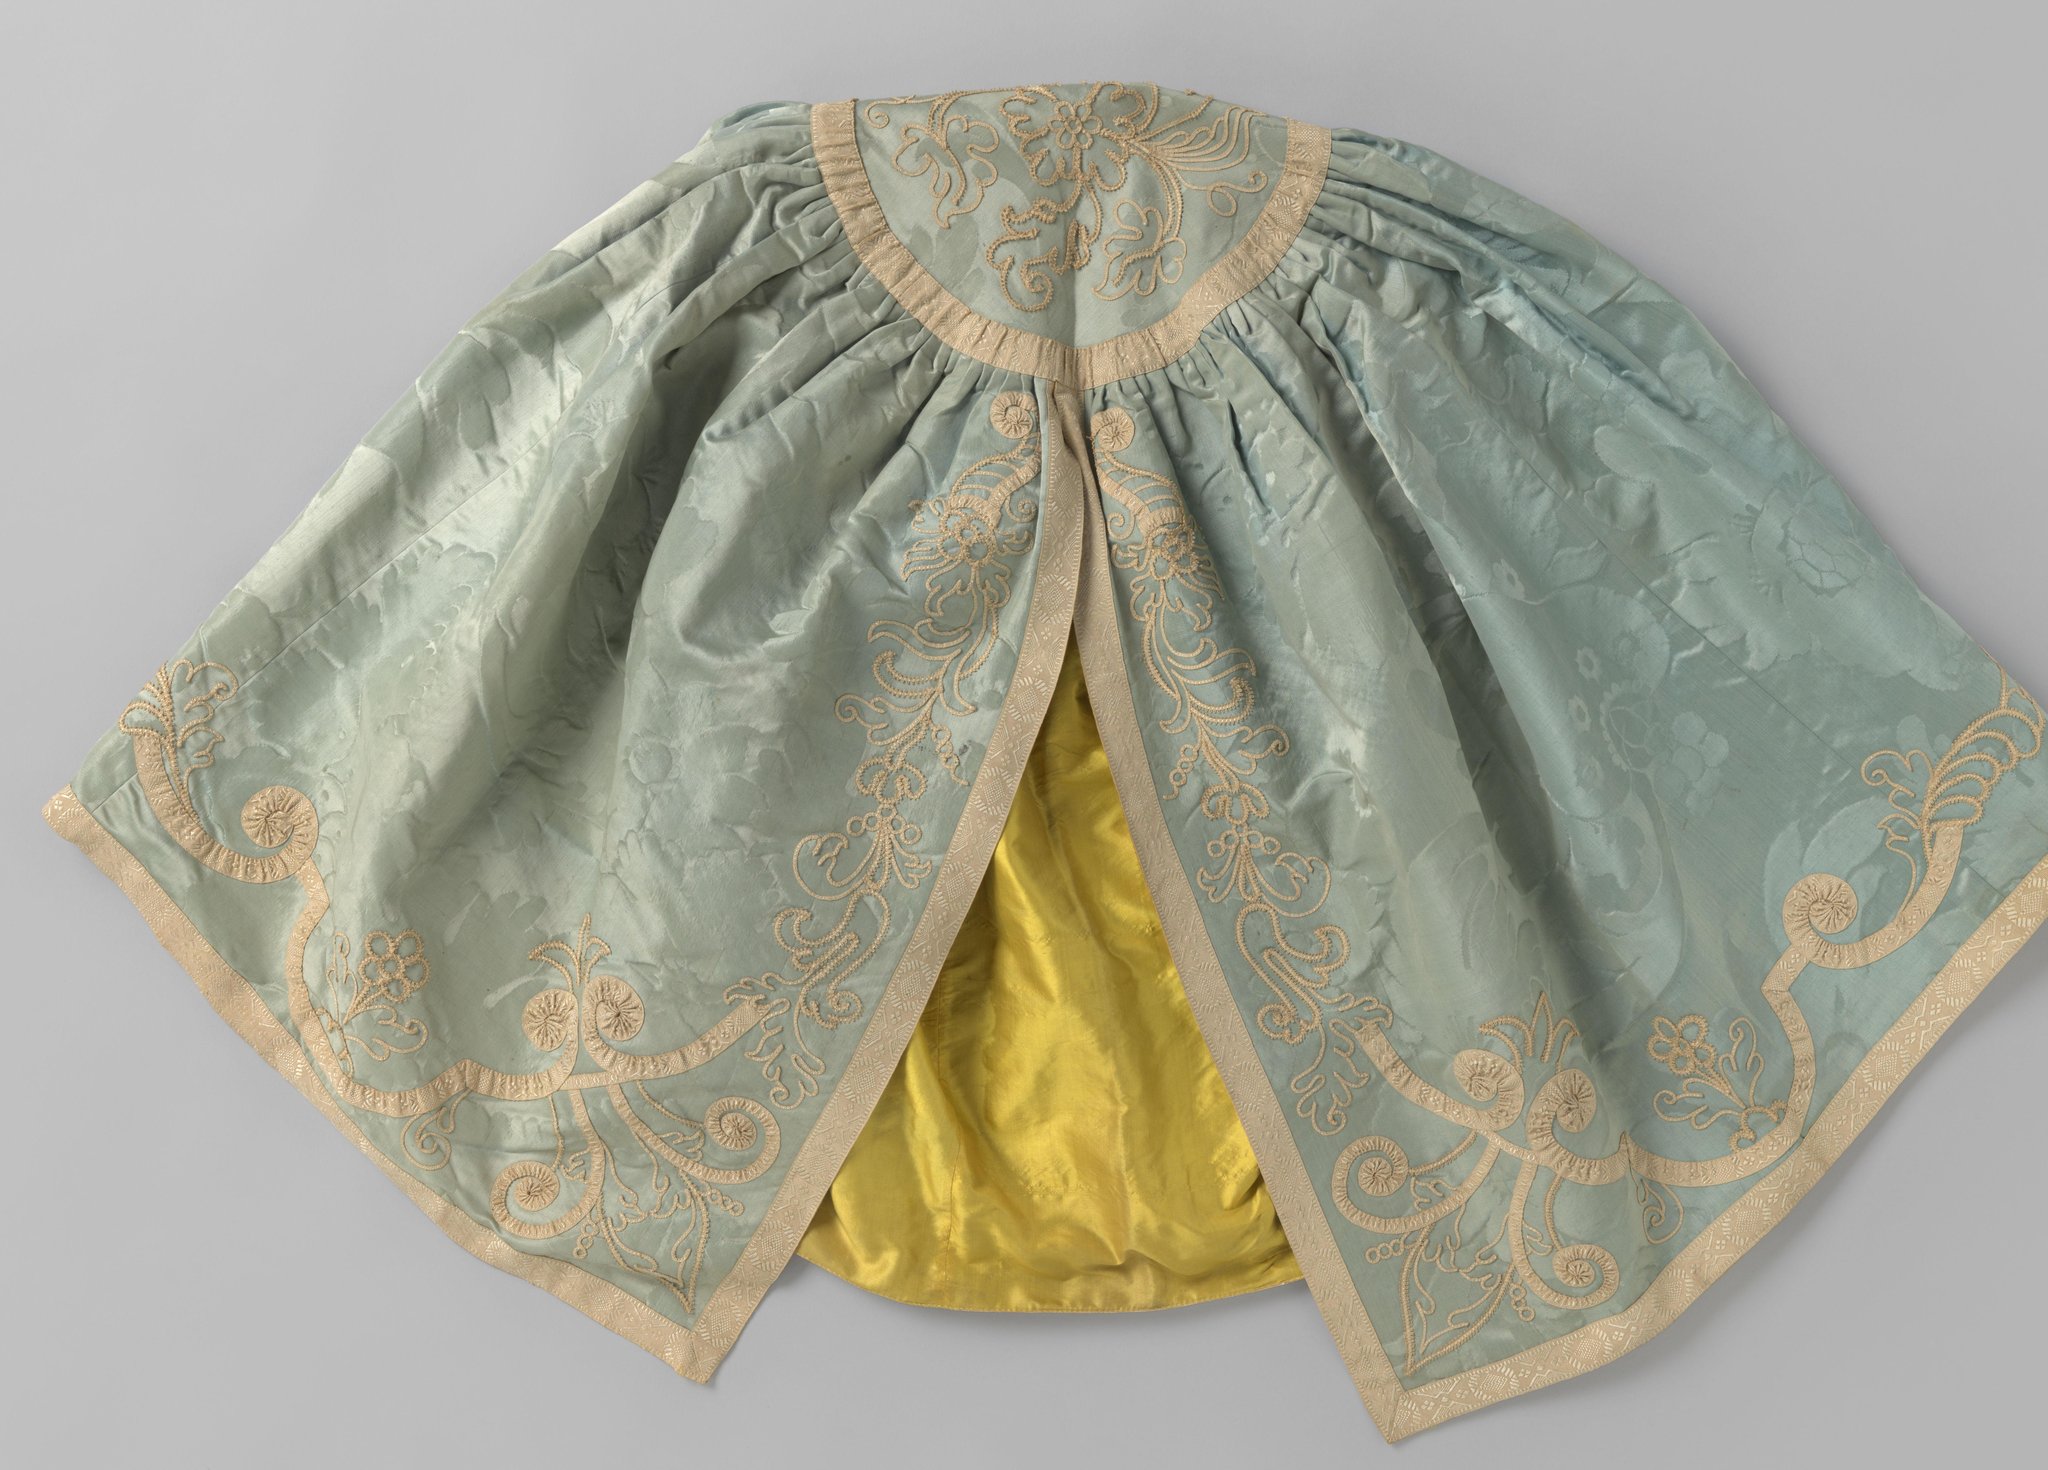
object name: vuurmandkleed, vuurmandskleed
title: Vuurmandkleed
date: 1650-1950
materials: silk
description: Vuurmandkleed van blauwe zijden damast met asymmetrisch patroon van grote bloemen. Afgezet met franje en passement dat in voluutranken, bloemen en kandelabermotieven is gelegd.